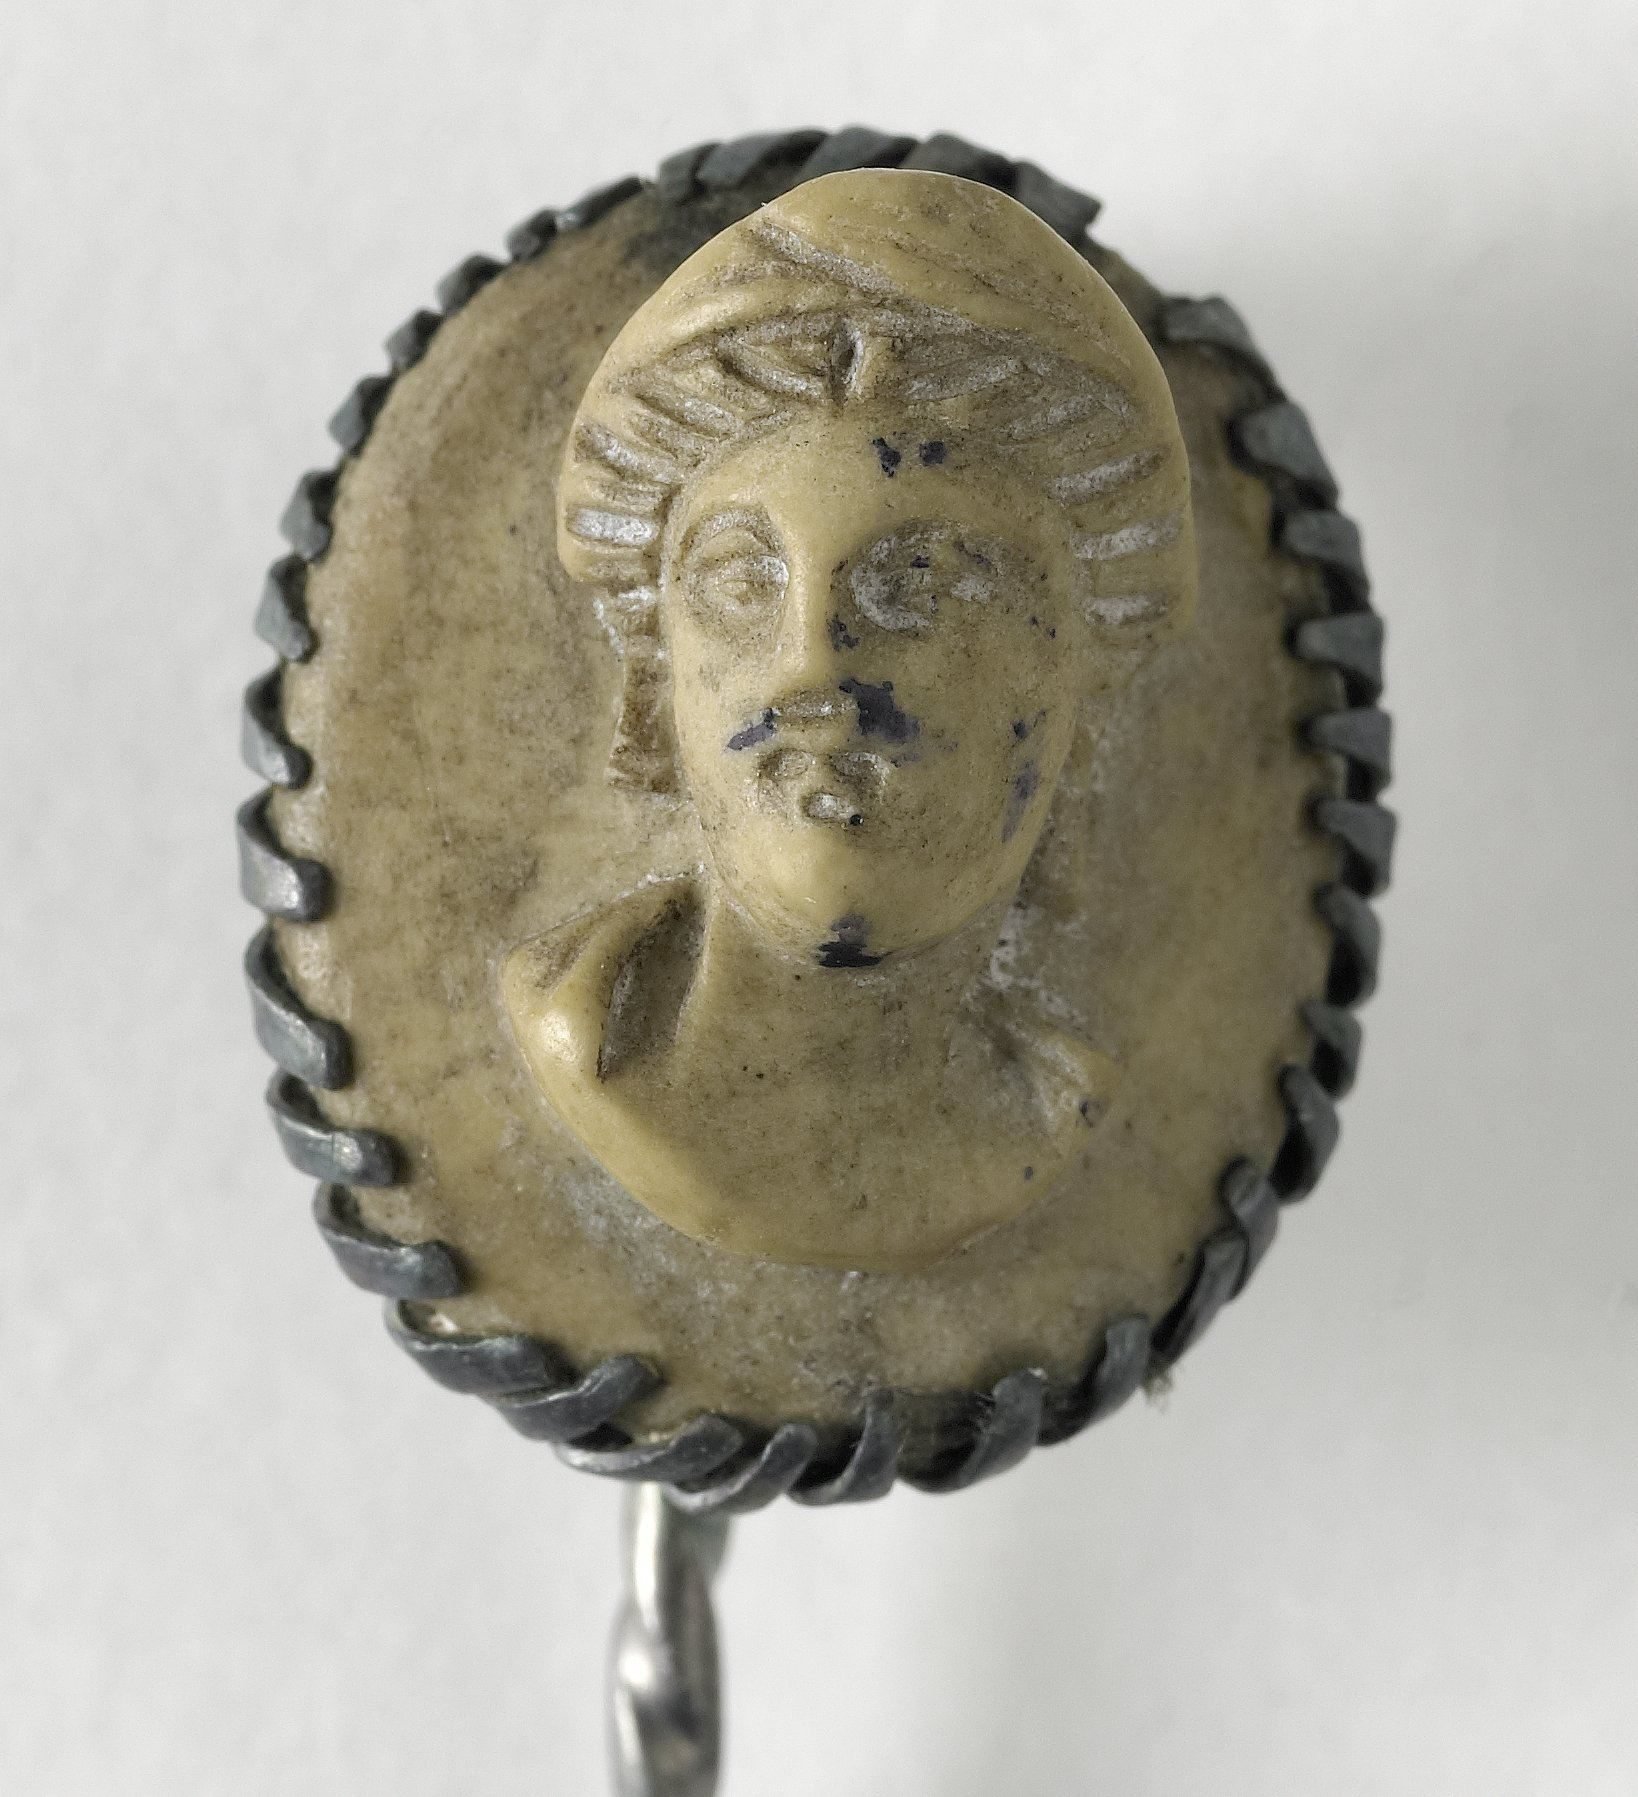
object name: pin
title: Speld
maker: Anonymous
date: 1850-1914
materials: silver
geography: belgium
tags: the hague, sculptor, bart van hove, leiden, amsterdam, painter, print maker, draughtsman, rembrandt van rijn, netherlands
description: Speld met ivoorkleurig ovaal medaillonportretje (Rembrandt?). De speld is eigendom geweest van Bart van Hove.